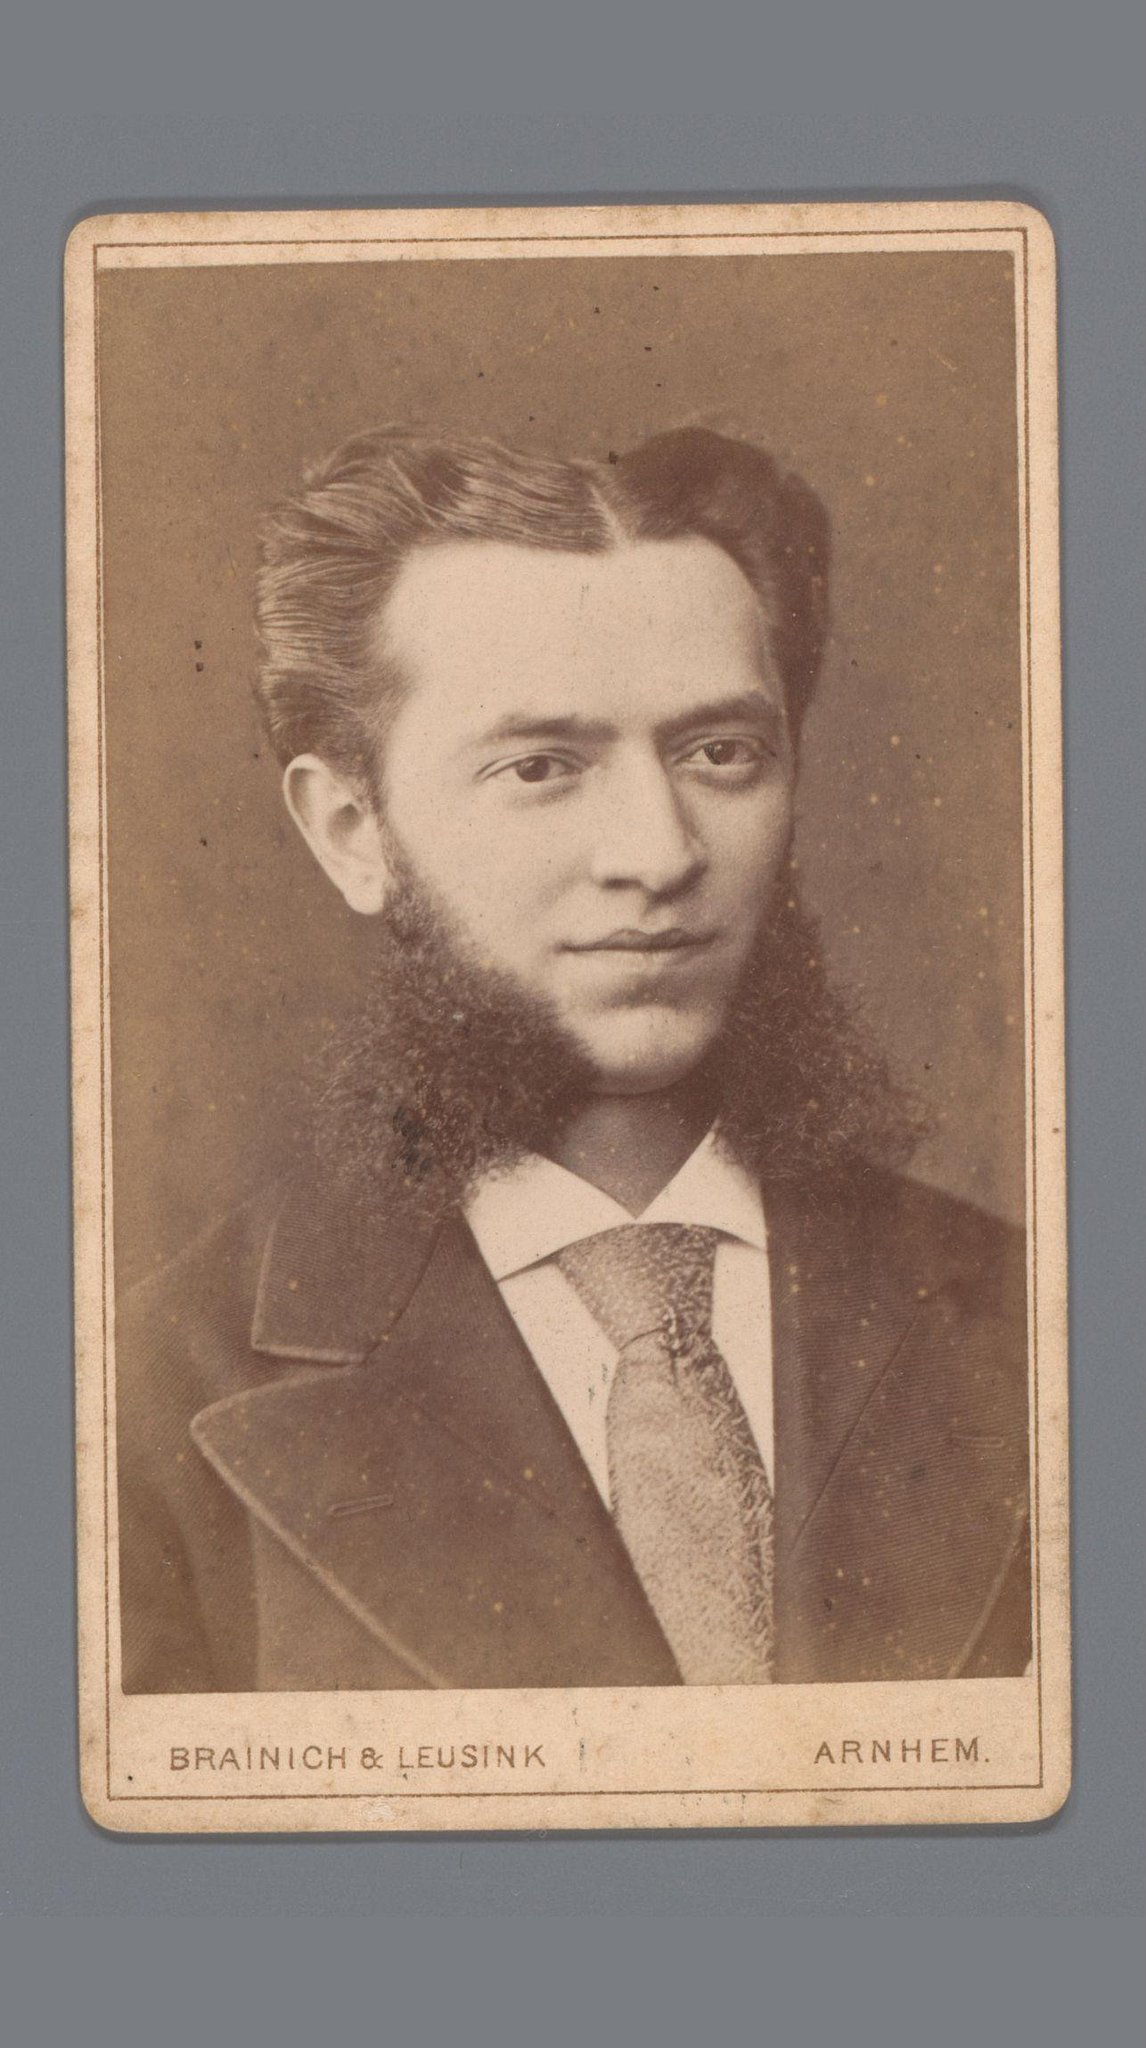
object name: photograph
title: Portret van een onbekende man met baard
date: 1881-1904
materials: cardboard, paper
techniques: albumen print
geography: arnhem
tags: adult man, anonymous historical person portrayed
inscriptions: address: ‘Menthensteeg No 7/ Arnhem.’, inscription: ‘De platen blijven voor nabestelling bewaard, ook worden/ vergrootingen naar ieder klein portret vervaardigd.’